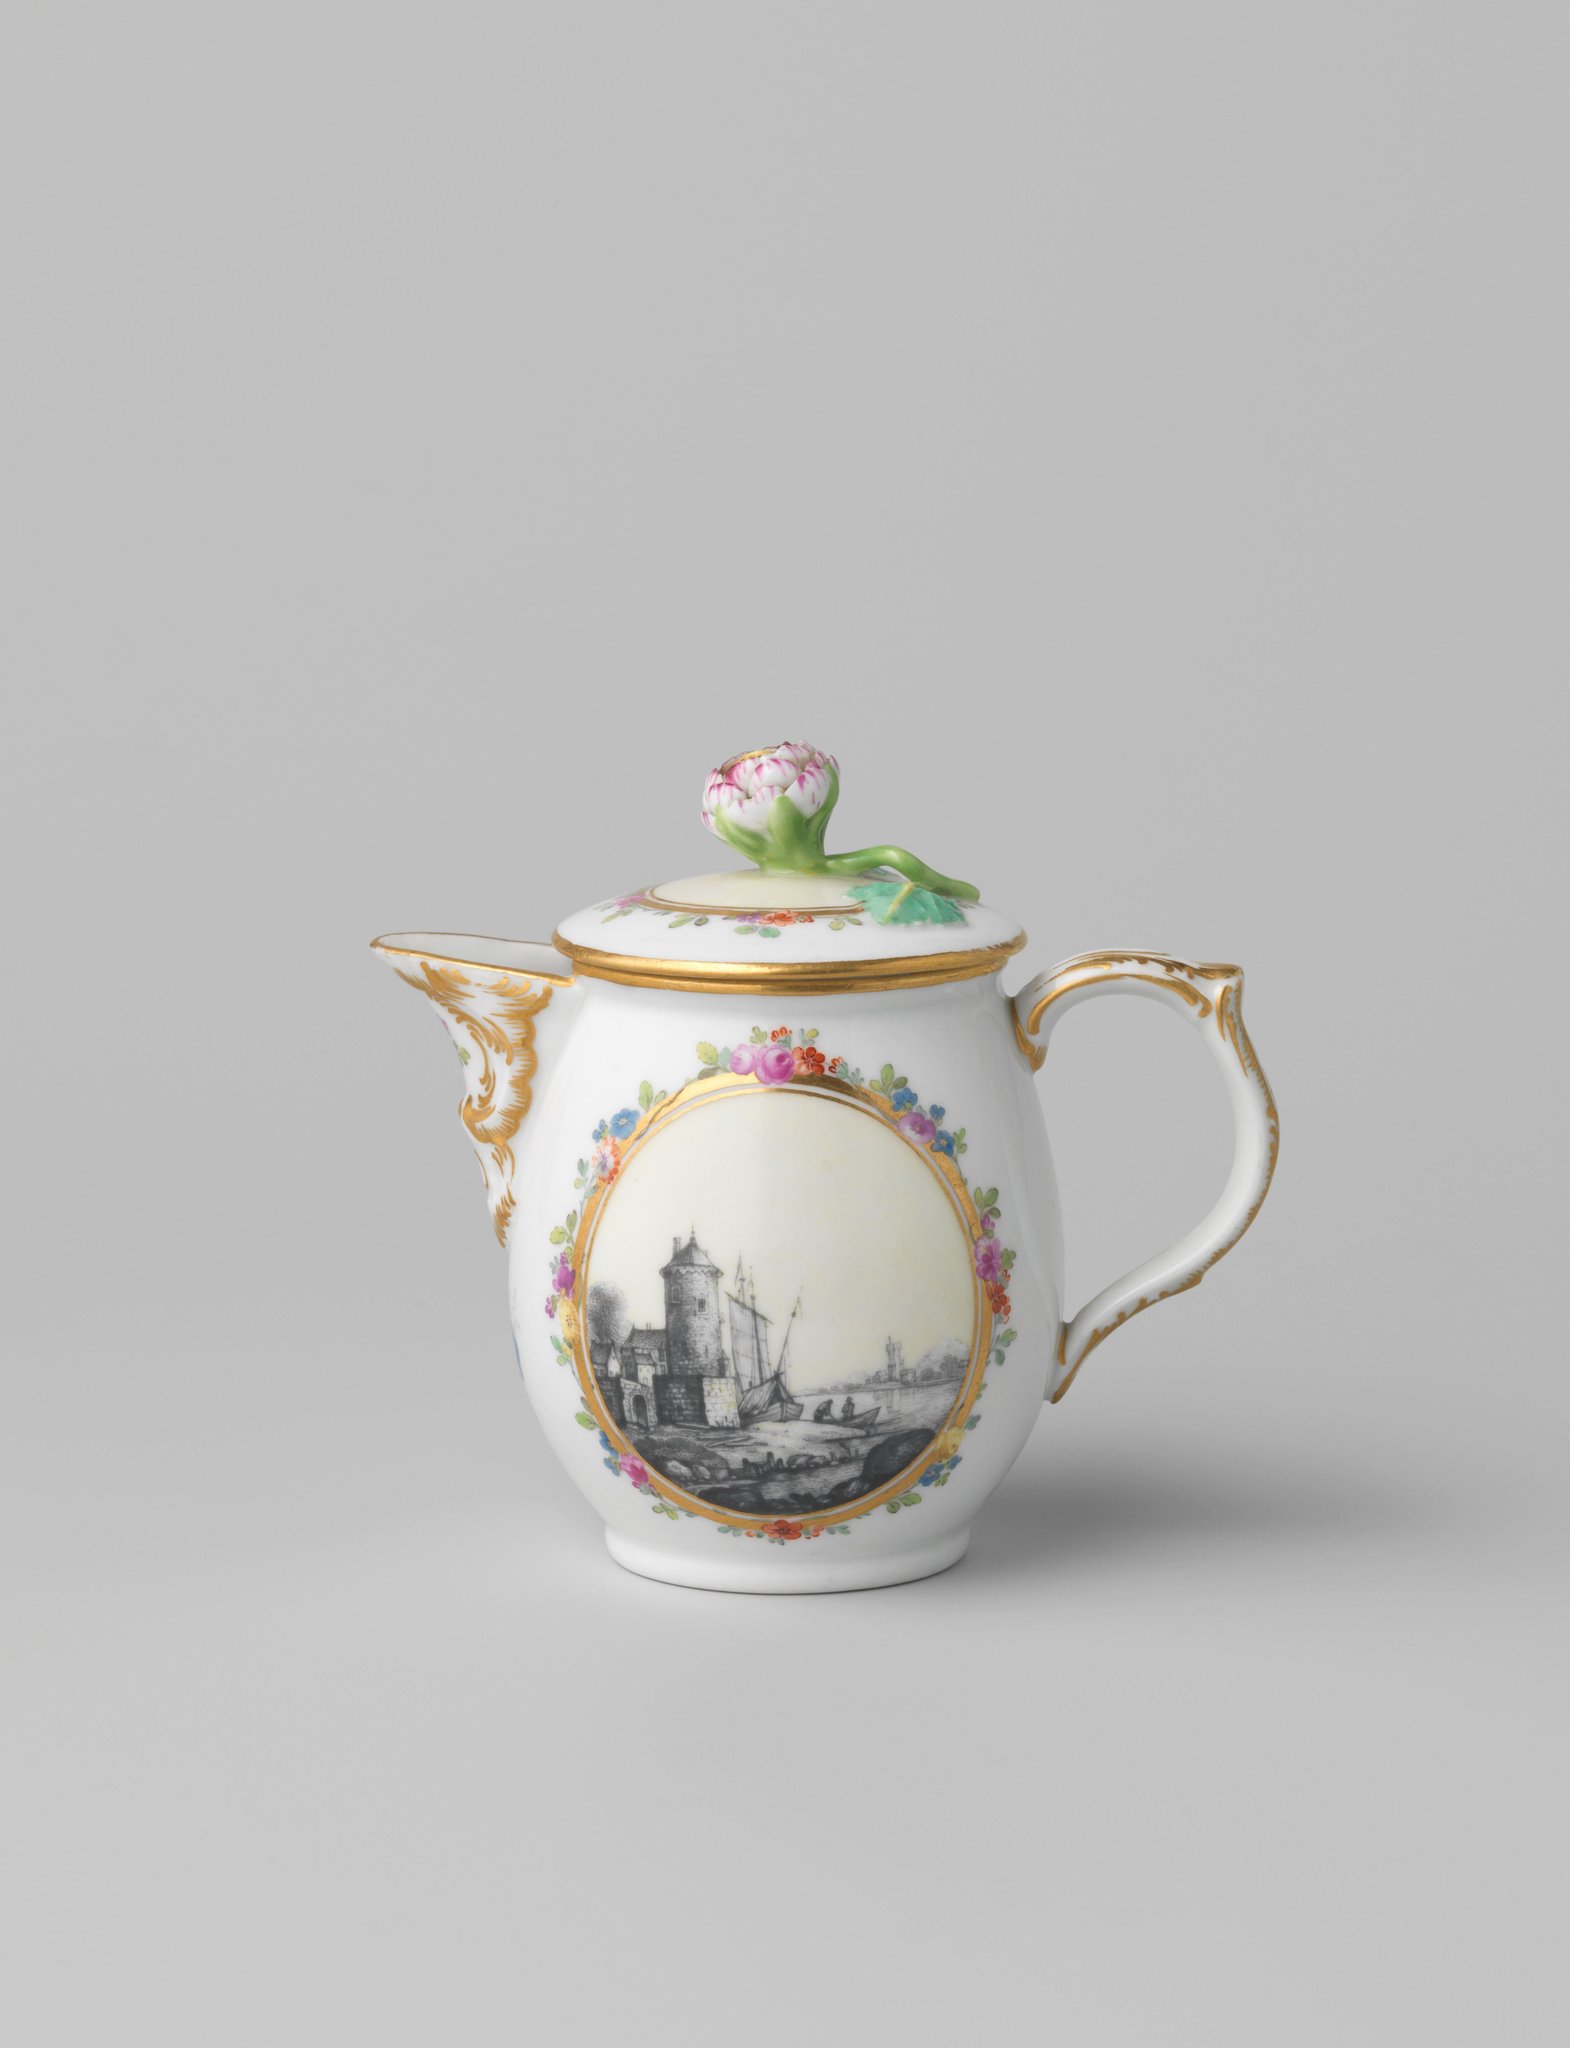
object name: milk jug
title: Milk jug with a landscape and flower sprays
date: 1780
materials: glaze, gold, paint, porcelain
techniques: firing, forming, gilding, turning, vitrification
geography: berlin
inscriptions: mark: ‘scepter/ III’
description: Melkkan van porselein met een eivormig lichaam, C-vormig oor en tuit vanuit de nek en rand. Beschilderd in emailkleuren en goud. Op de buik tweemaal een medaillon van bloemtakken met daarin een landschap. Het oor en de tuit zijn versierd in rocaillestijl. De deksel met een vergelijkbare decoratie; dekselknop in de vorm van een bloem. Gemerkt op de onderzijde met de scepter en III.